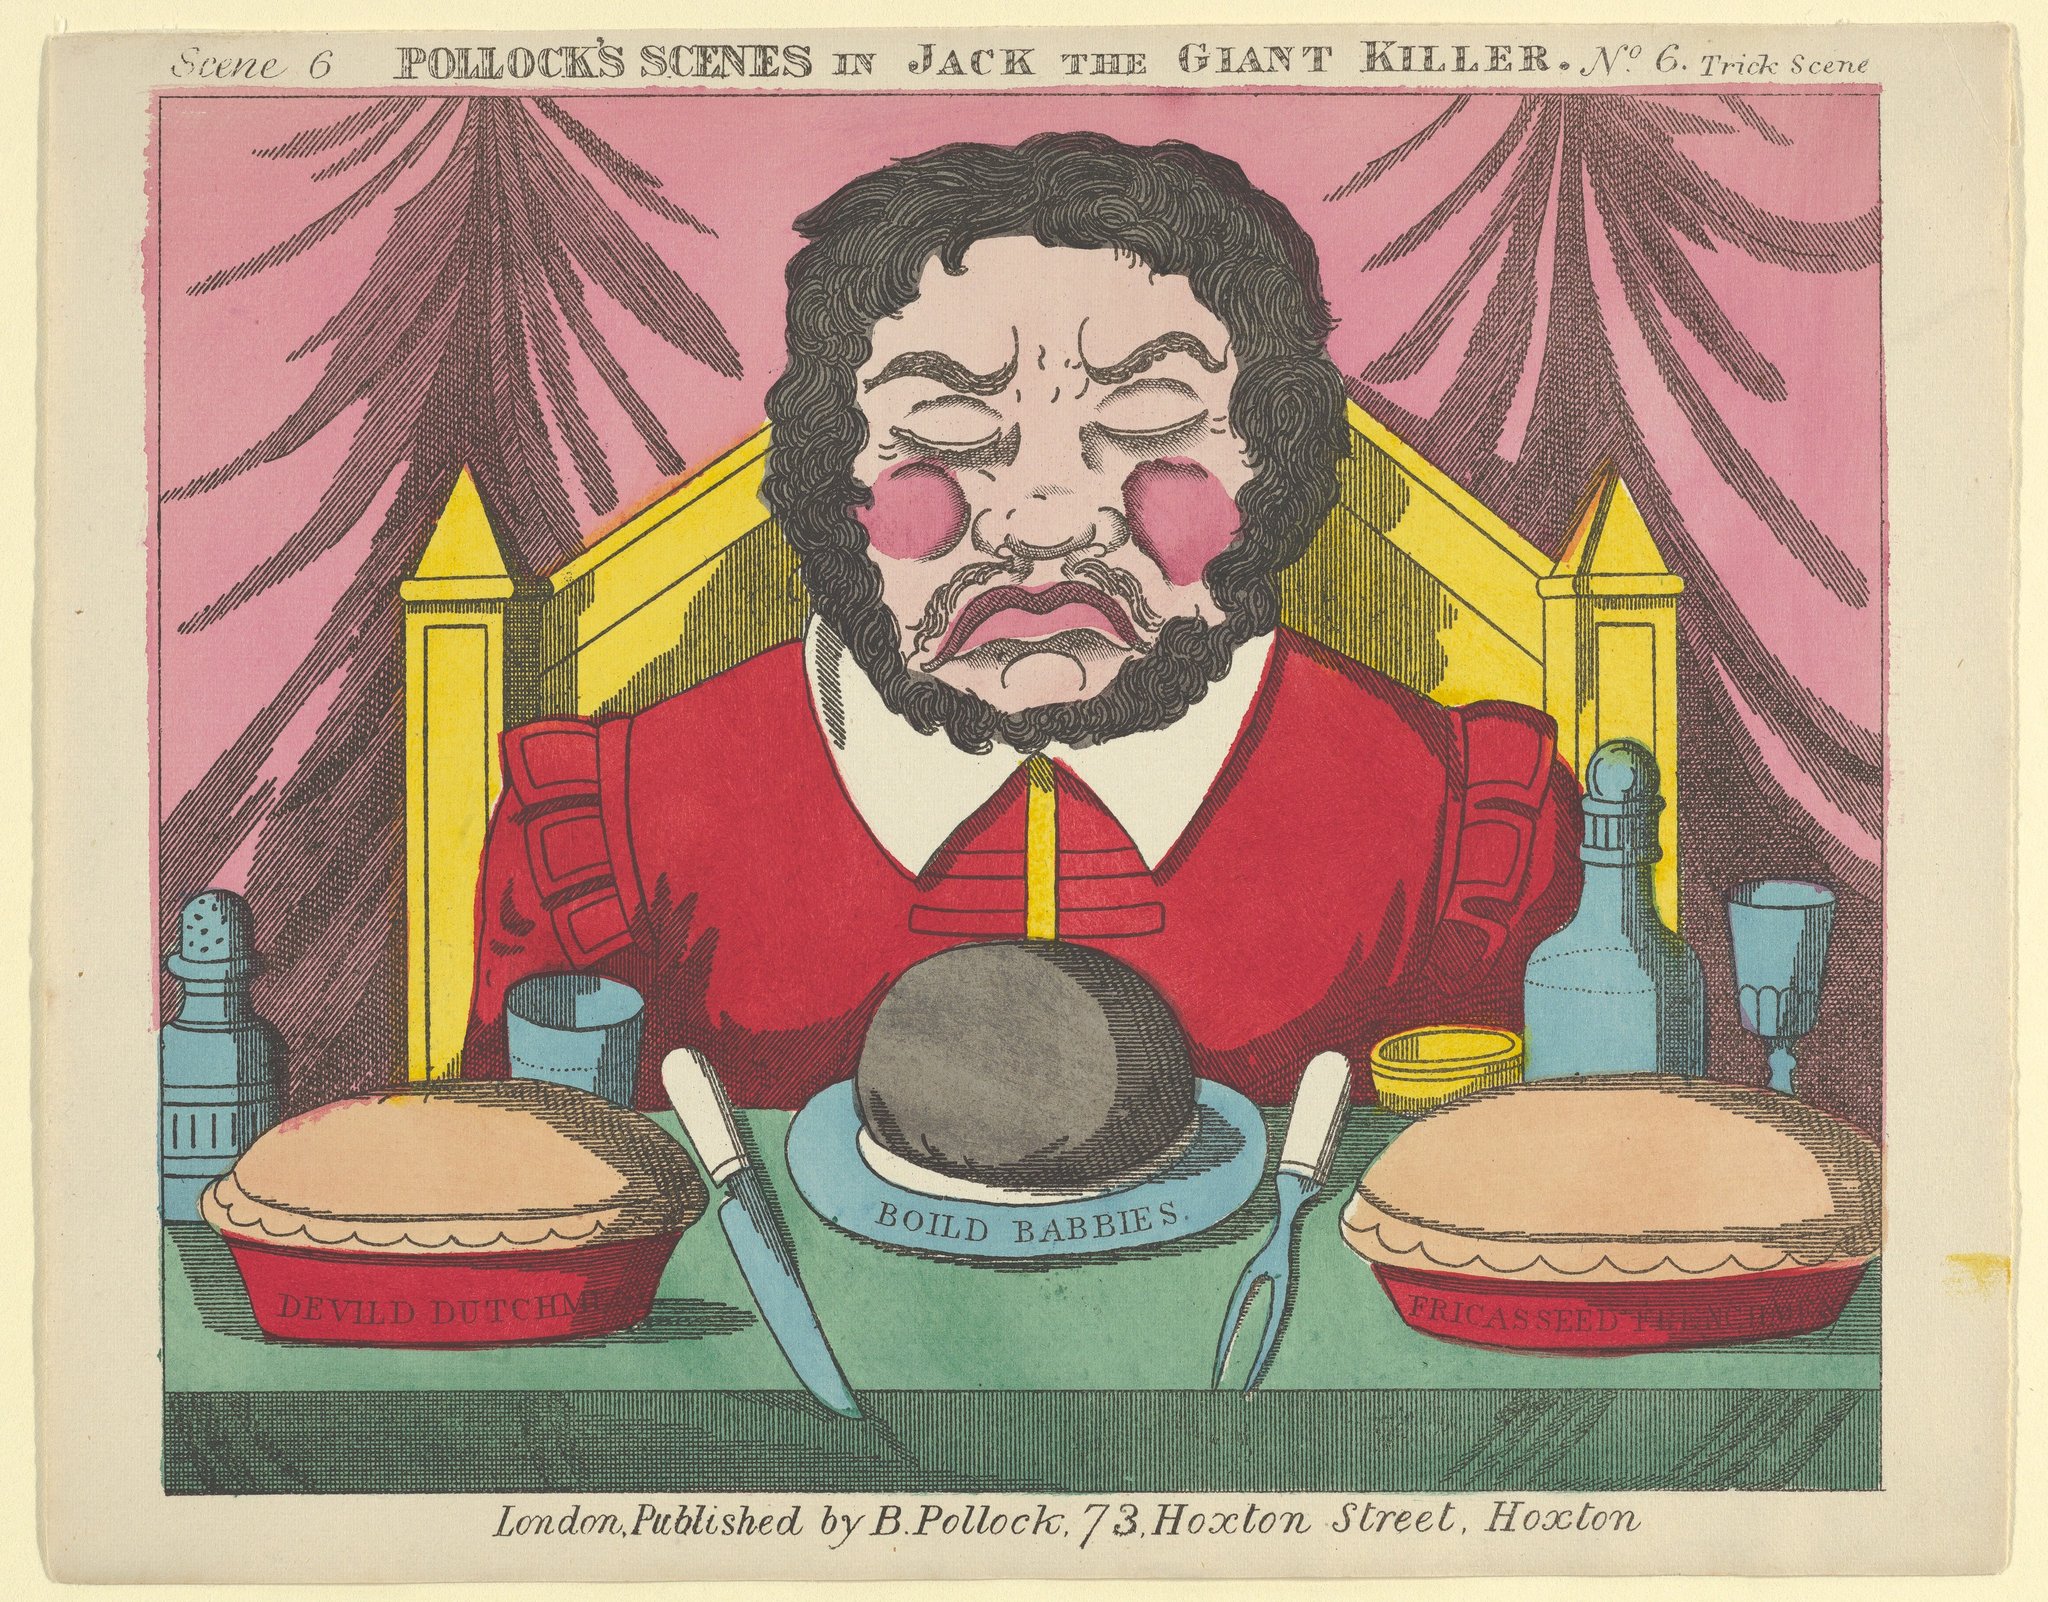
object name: print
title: Scene 6, from Jack and the Giant Killer, Scenes for a Toy Theater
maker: benjamin pollock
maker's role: publisher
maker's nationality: british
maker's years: 1857-1937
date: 1870-1890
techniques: lithograph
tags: men